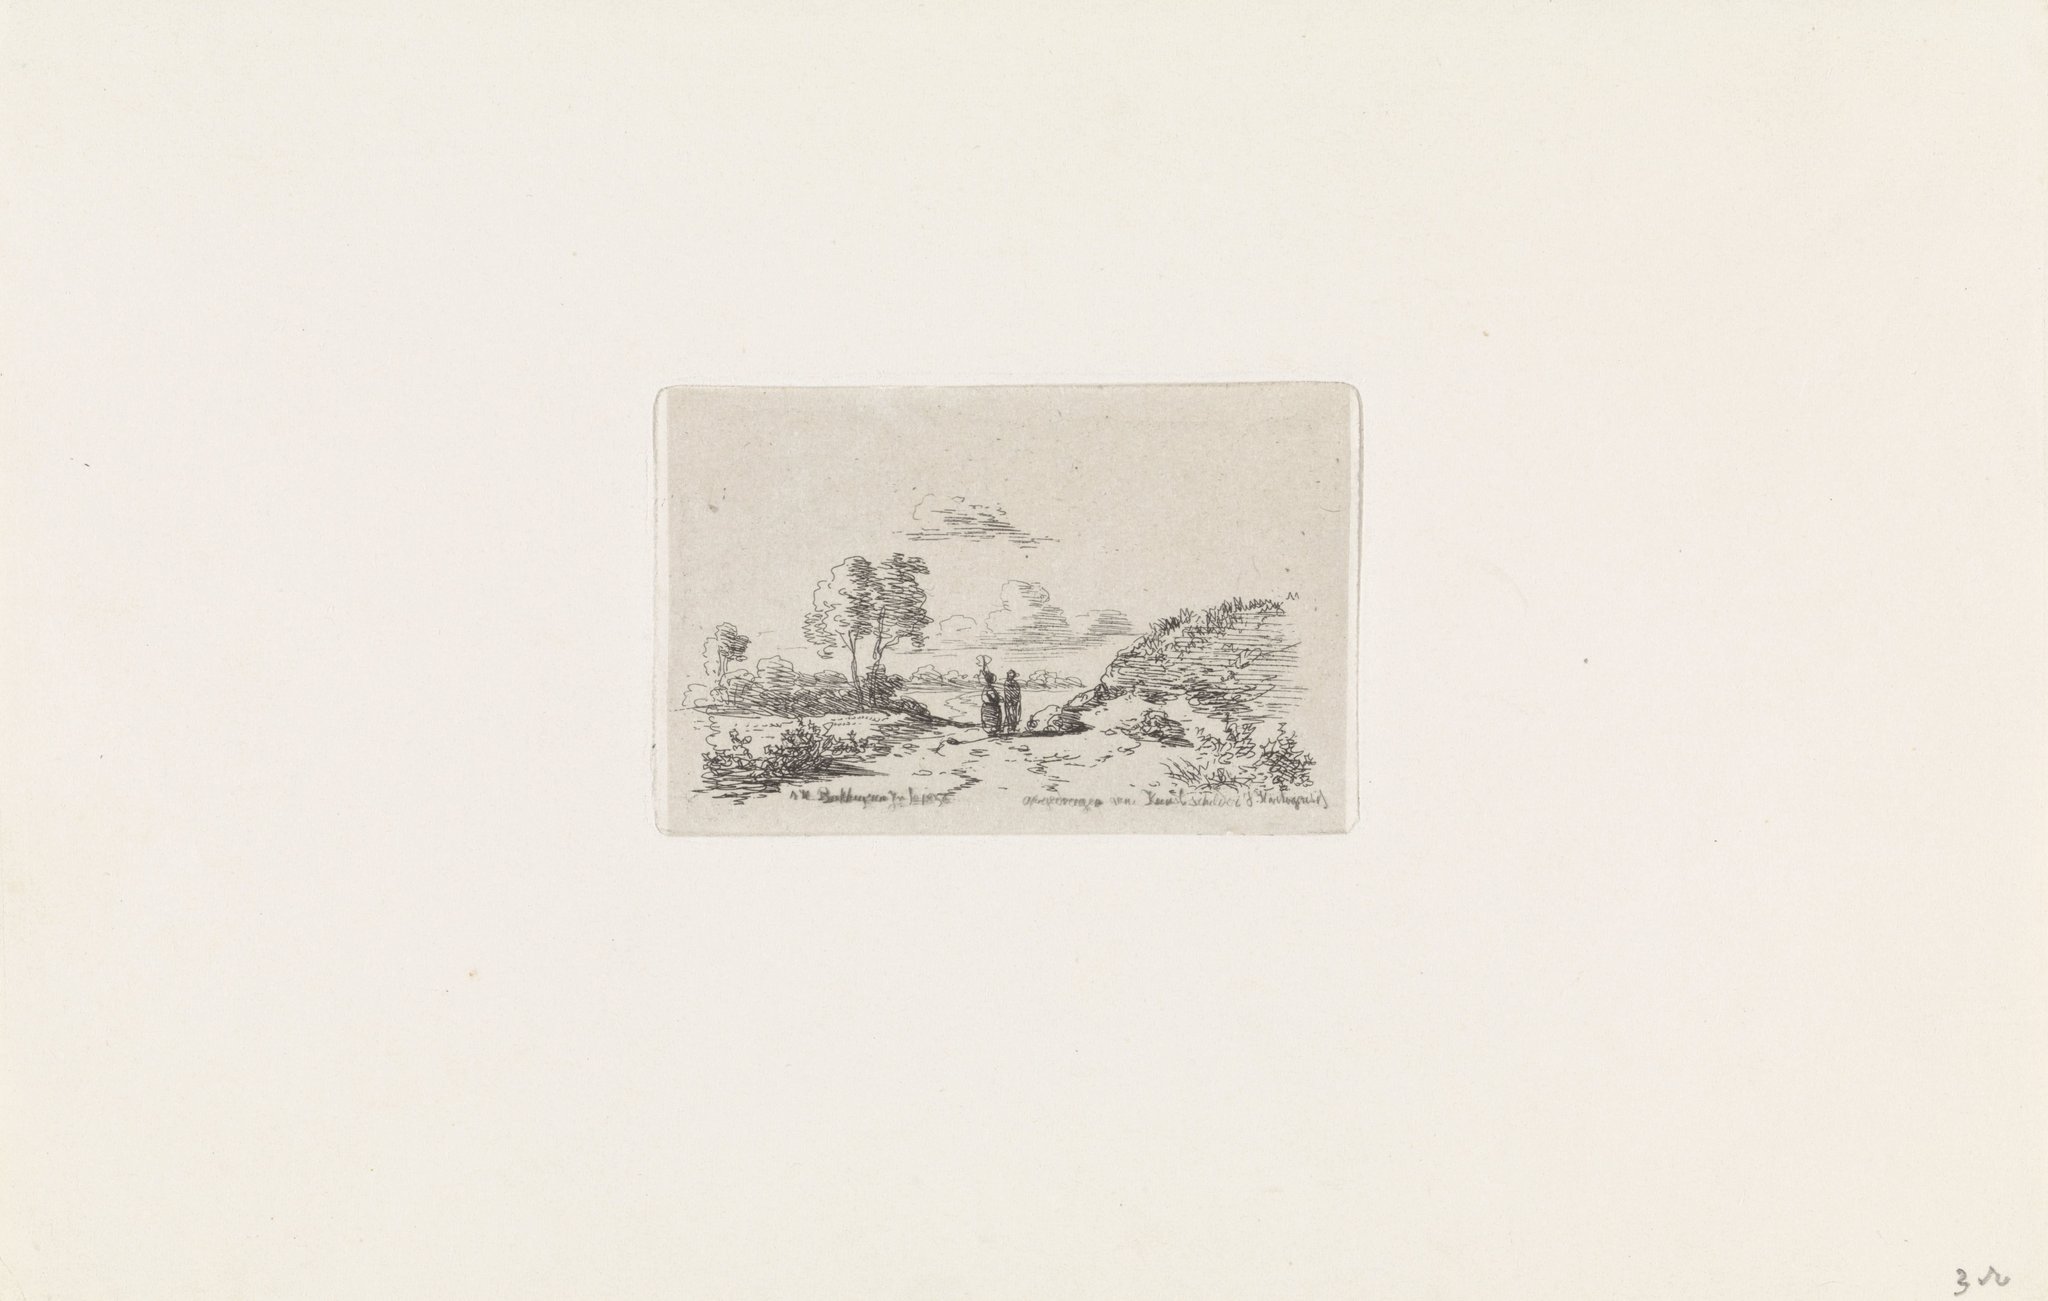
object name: print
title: Landschap met twee figuren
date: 1856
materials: paper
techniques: etching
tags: landscapes in the temperate zone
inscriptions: collector's mark: Lugt 2228